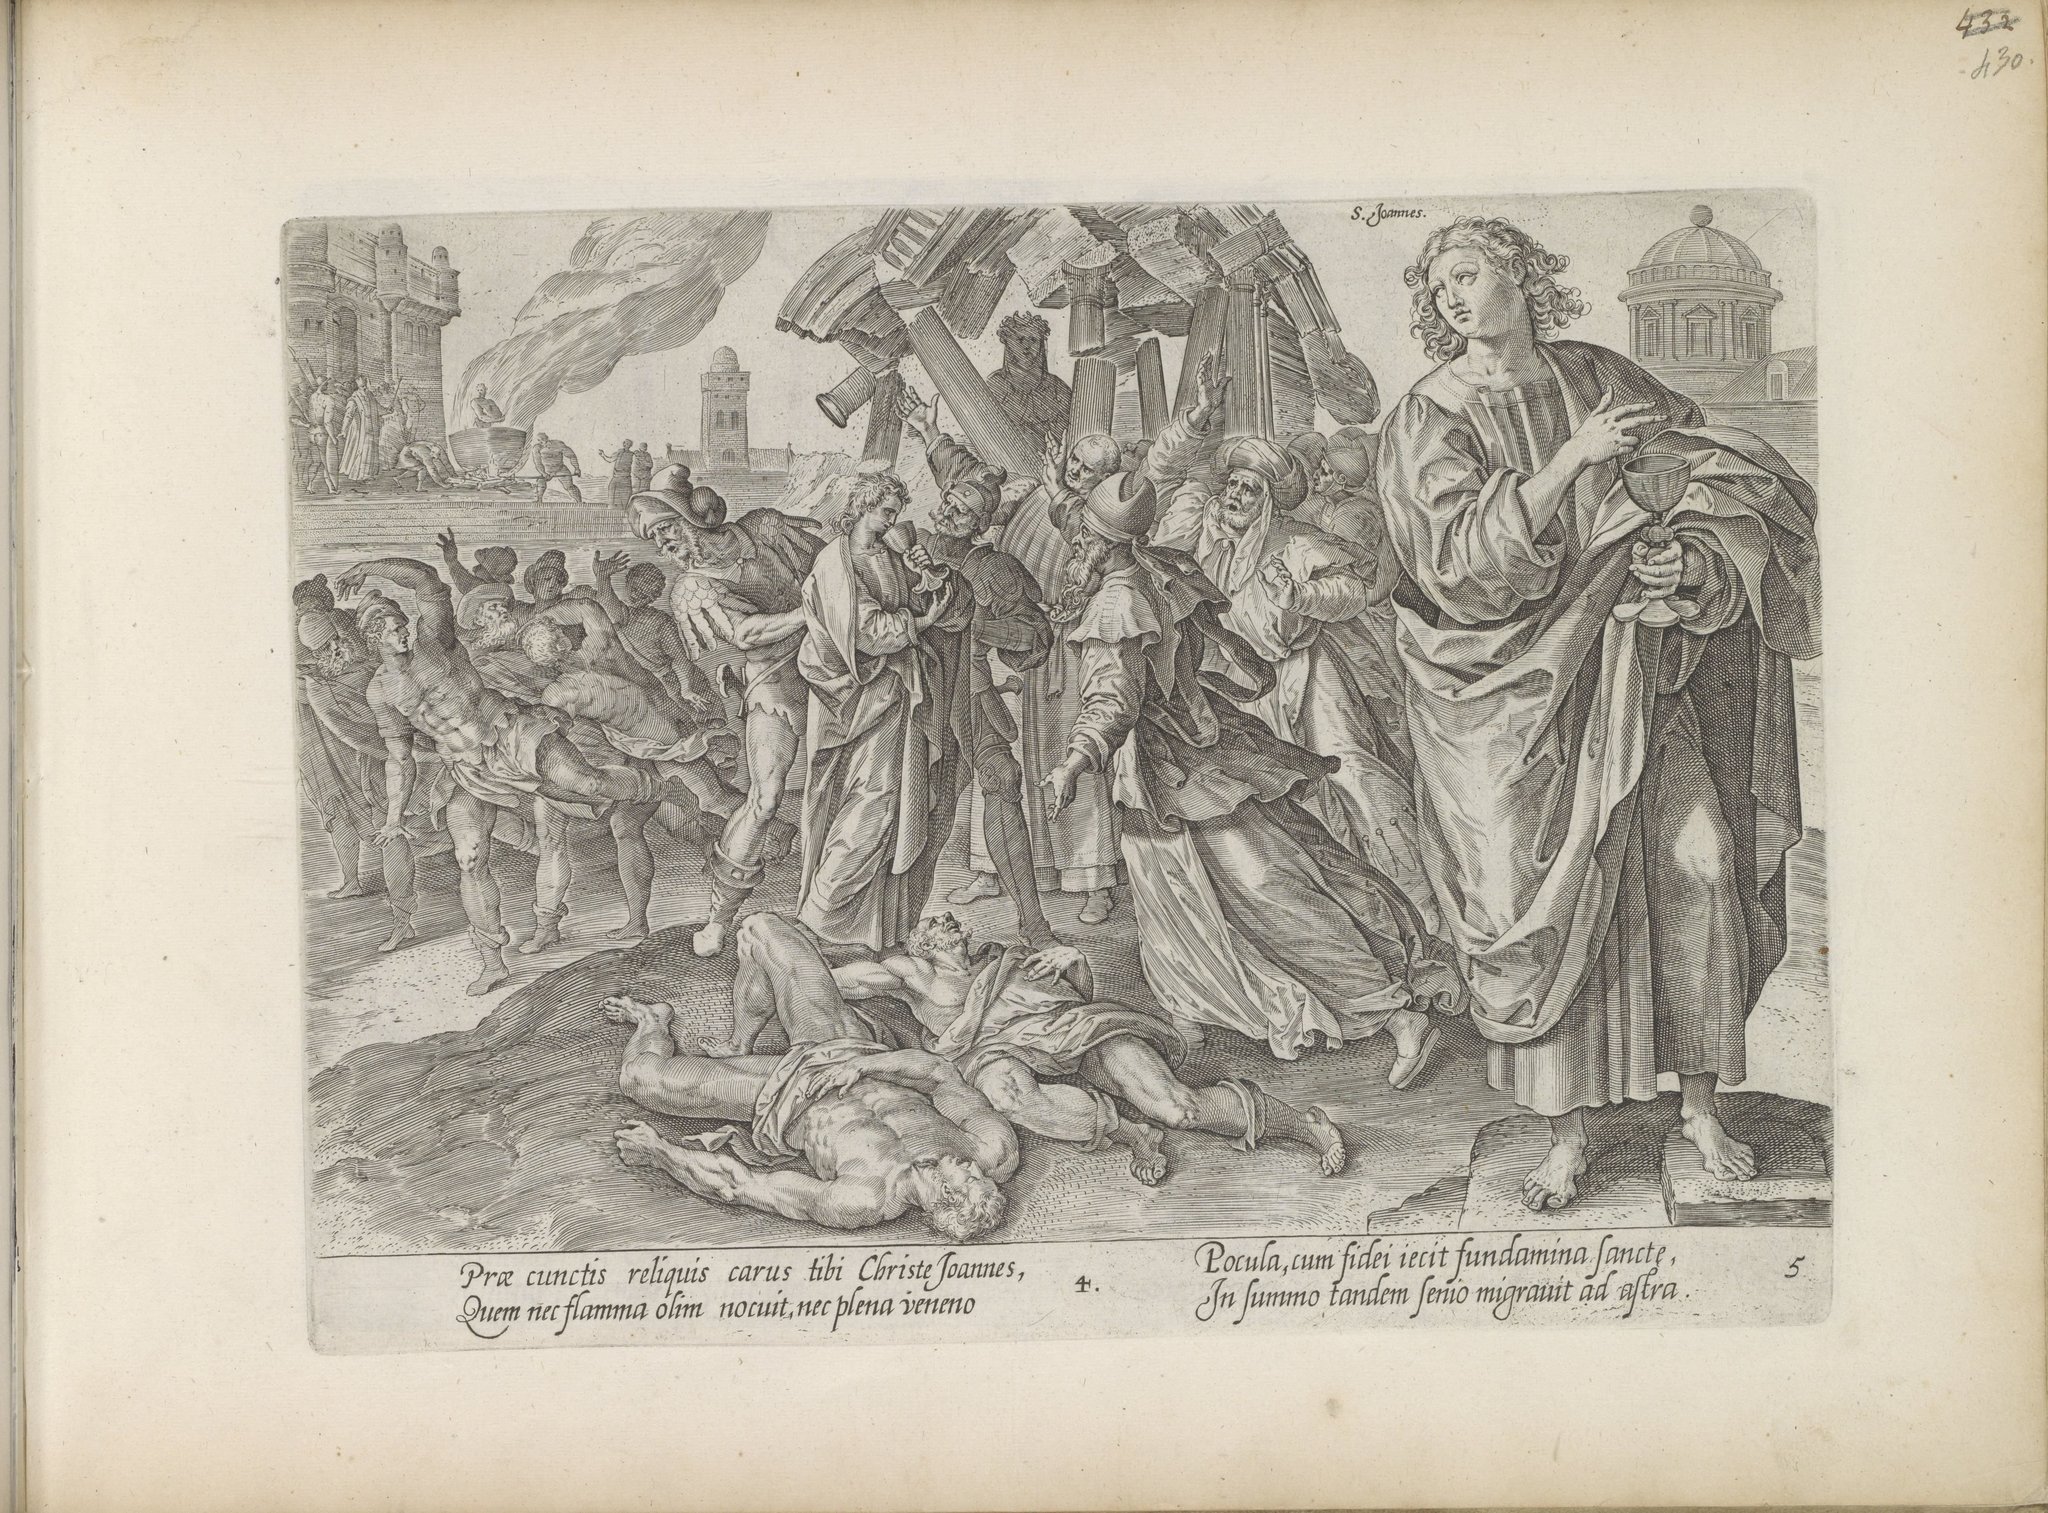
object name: print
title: Martelaarschap van Christus en de apostelen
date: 1576-1580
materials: paper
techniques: engraving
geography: amsterdam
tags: john drinks from the poisoned chalice, given to him by the priest of diana of ephesus; john resuscitates two women who had already died from the poison, martyrdom of john in front of the porta latina: he is put in a cauldron of boiling oil, but remains unharmed, the apostle john the evangelist; possible attributes: book, cauldron, chalice with snake, eagle, palm, scroll - martyrdom, suffering, misfortune, death of male saint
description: Rechts op de voorgrond staat Johannes met een beker in de hand. Deze apostel stierf een natuurlijke dood, maar doorstond wel enige martelingen. Die zijn achter hem te zien: uiterst linksboven staat hij in een pan kokende olie, op het middenplan is te zien hoe hij een beker gif leegdrinkt. Onder de voorstelling een verklarende tekst in het Latijn. Deze prent maakt deel uit van een album.